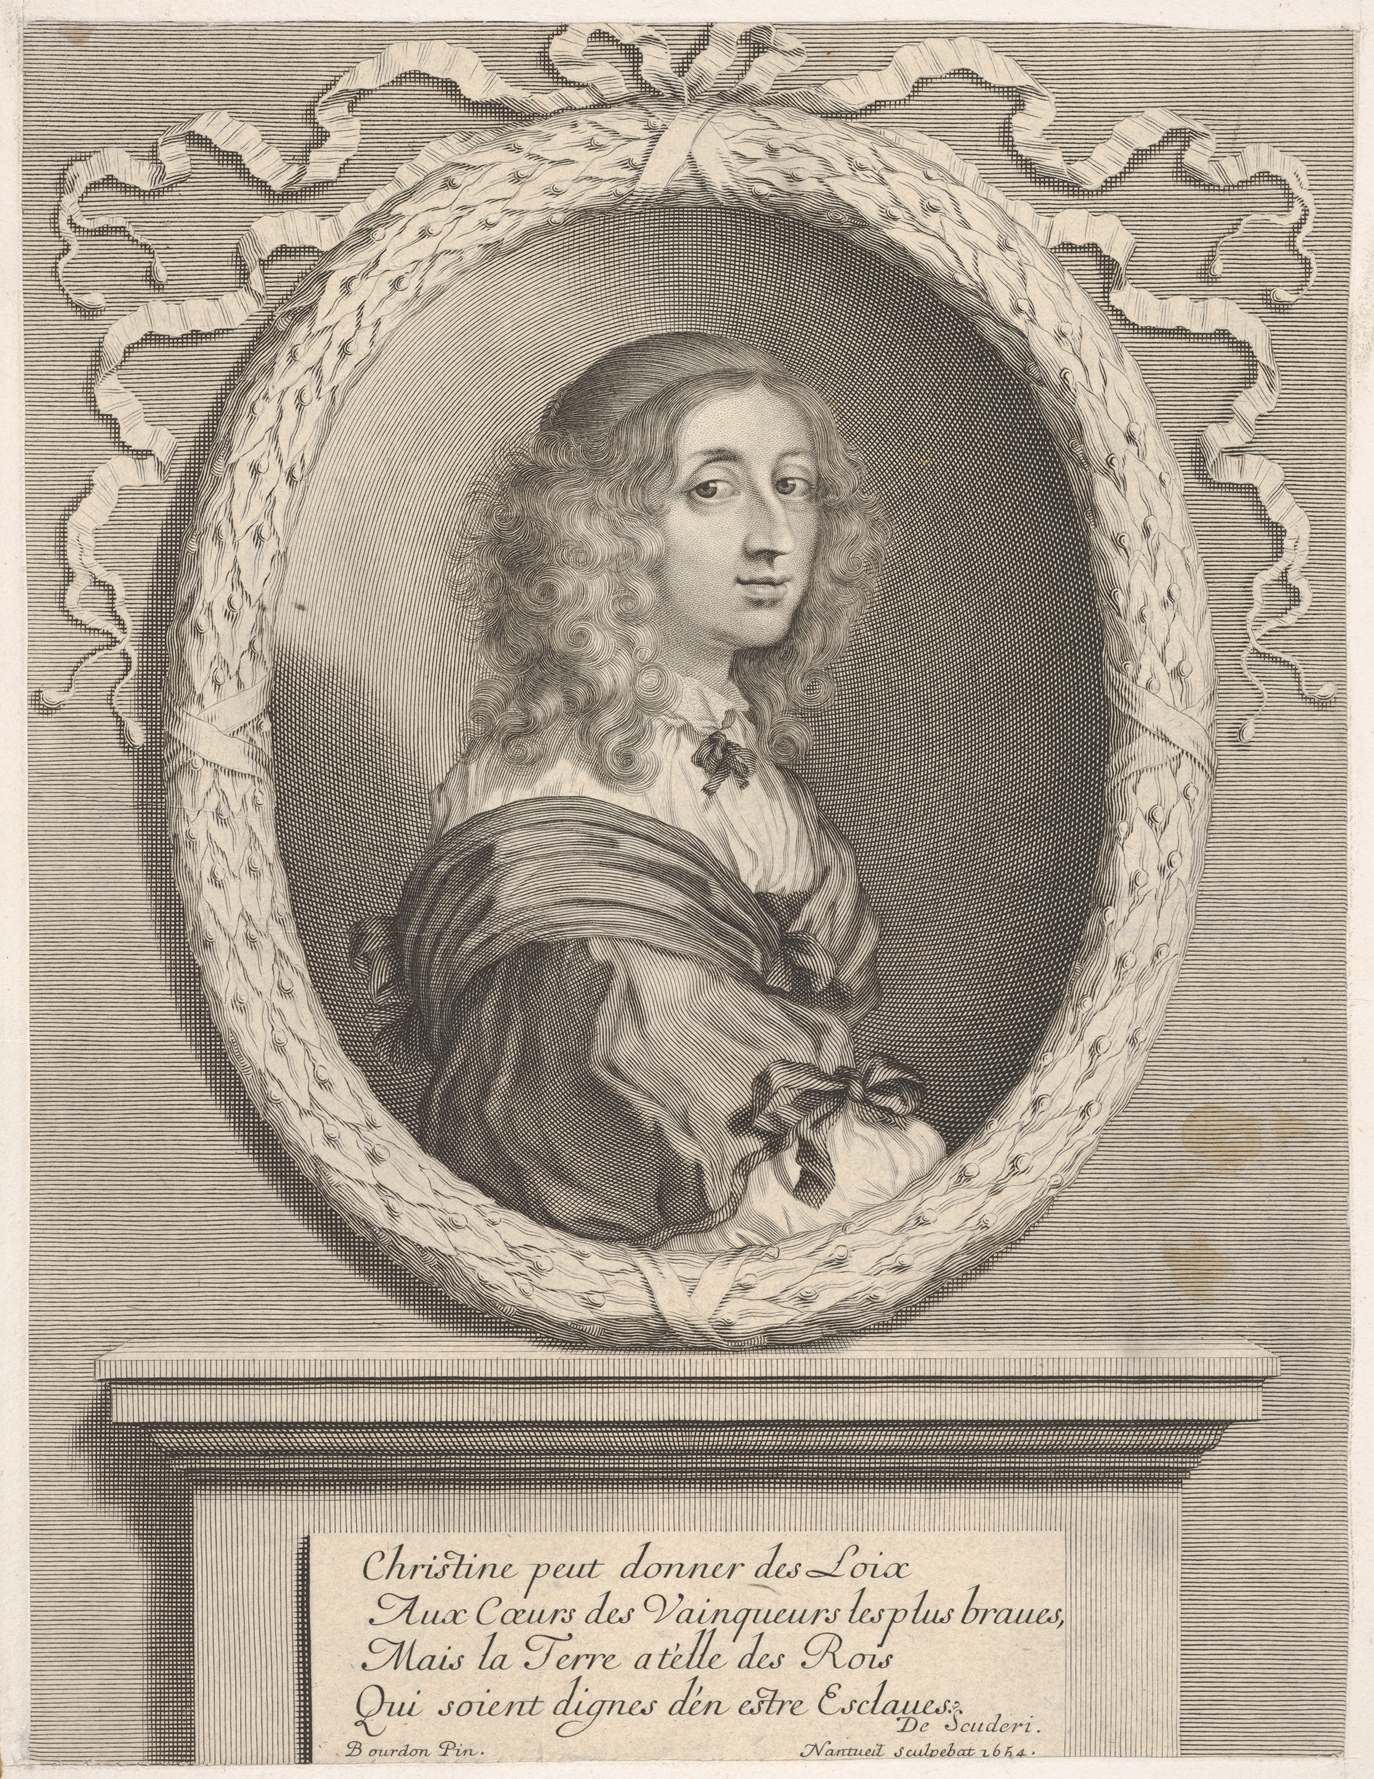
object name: print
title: Christine, reine de Suède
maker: robert nanteuil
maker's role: artist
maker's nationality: french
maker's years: 1623-1678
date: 1654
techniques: engraving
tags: portraits,women